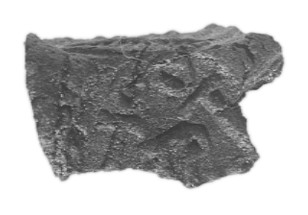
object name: sealing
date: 2030-1640 BCE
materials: clay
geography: egypt